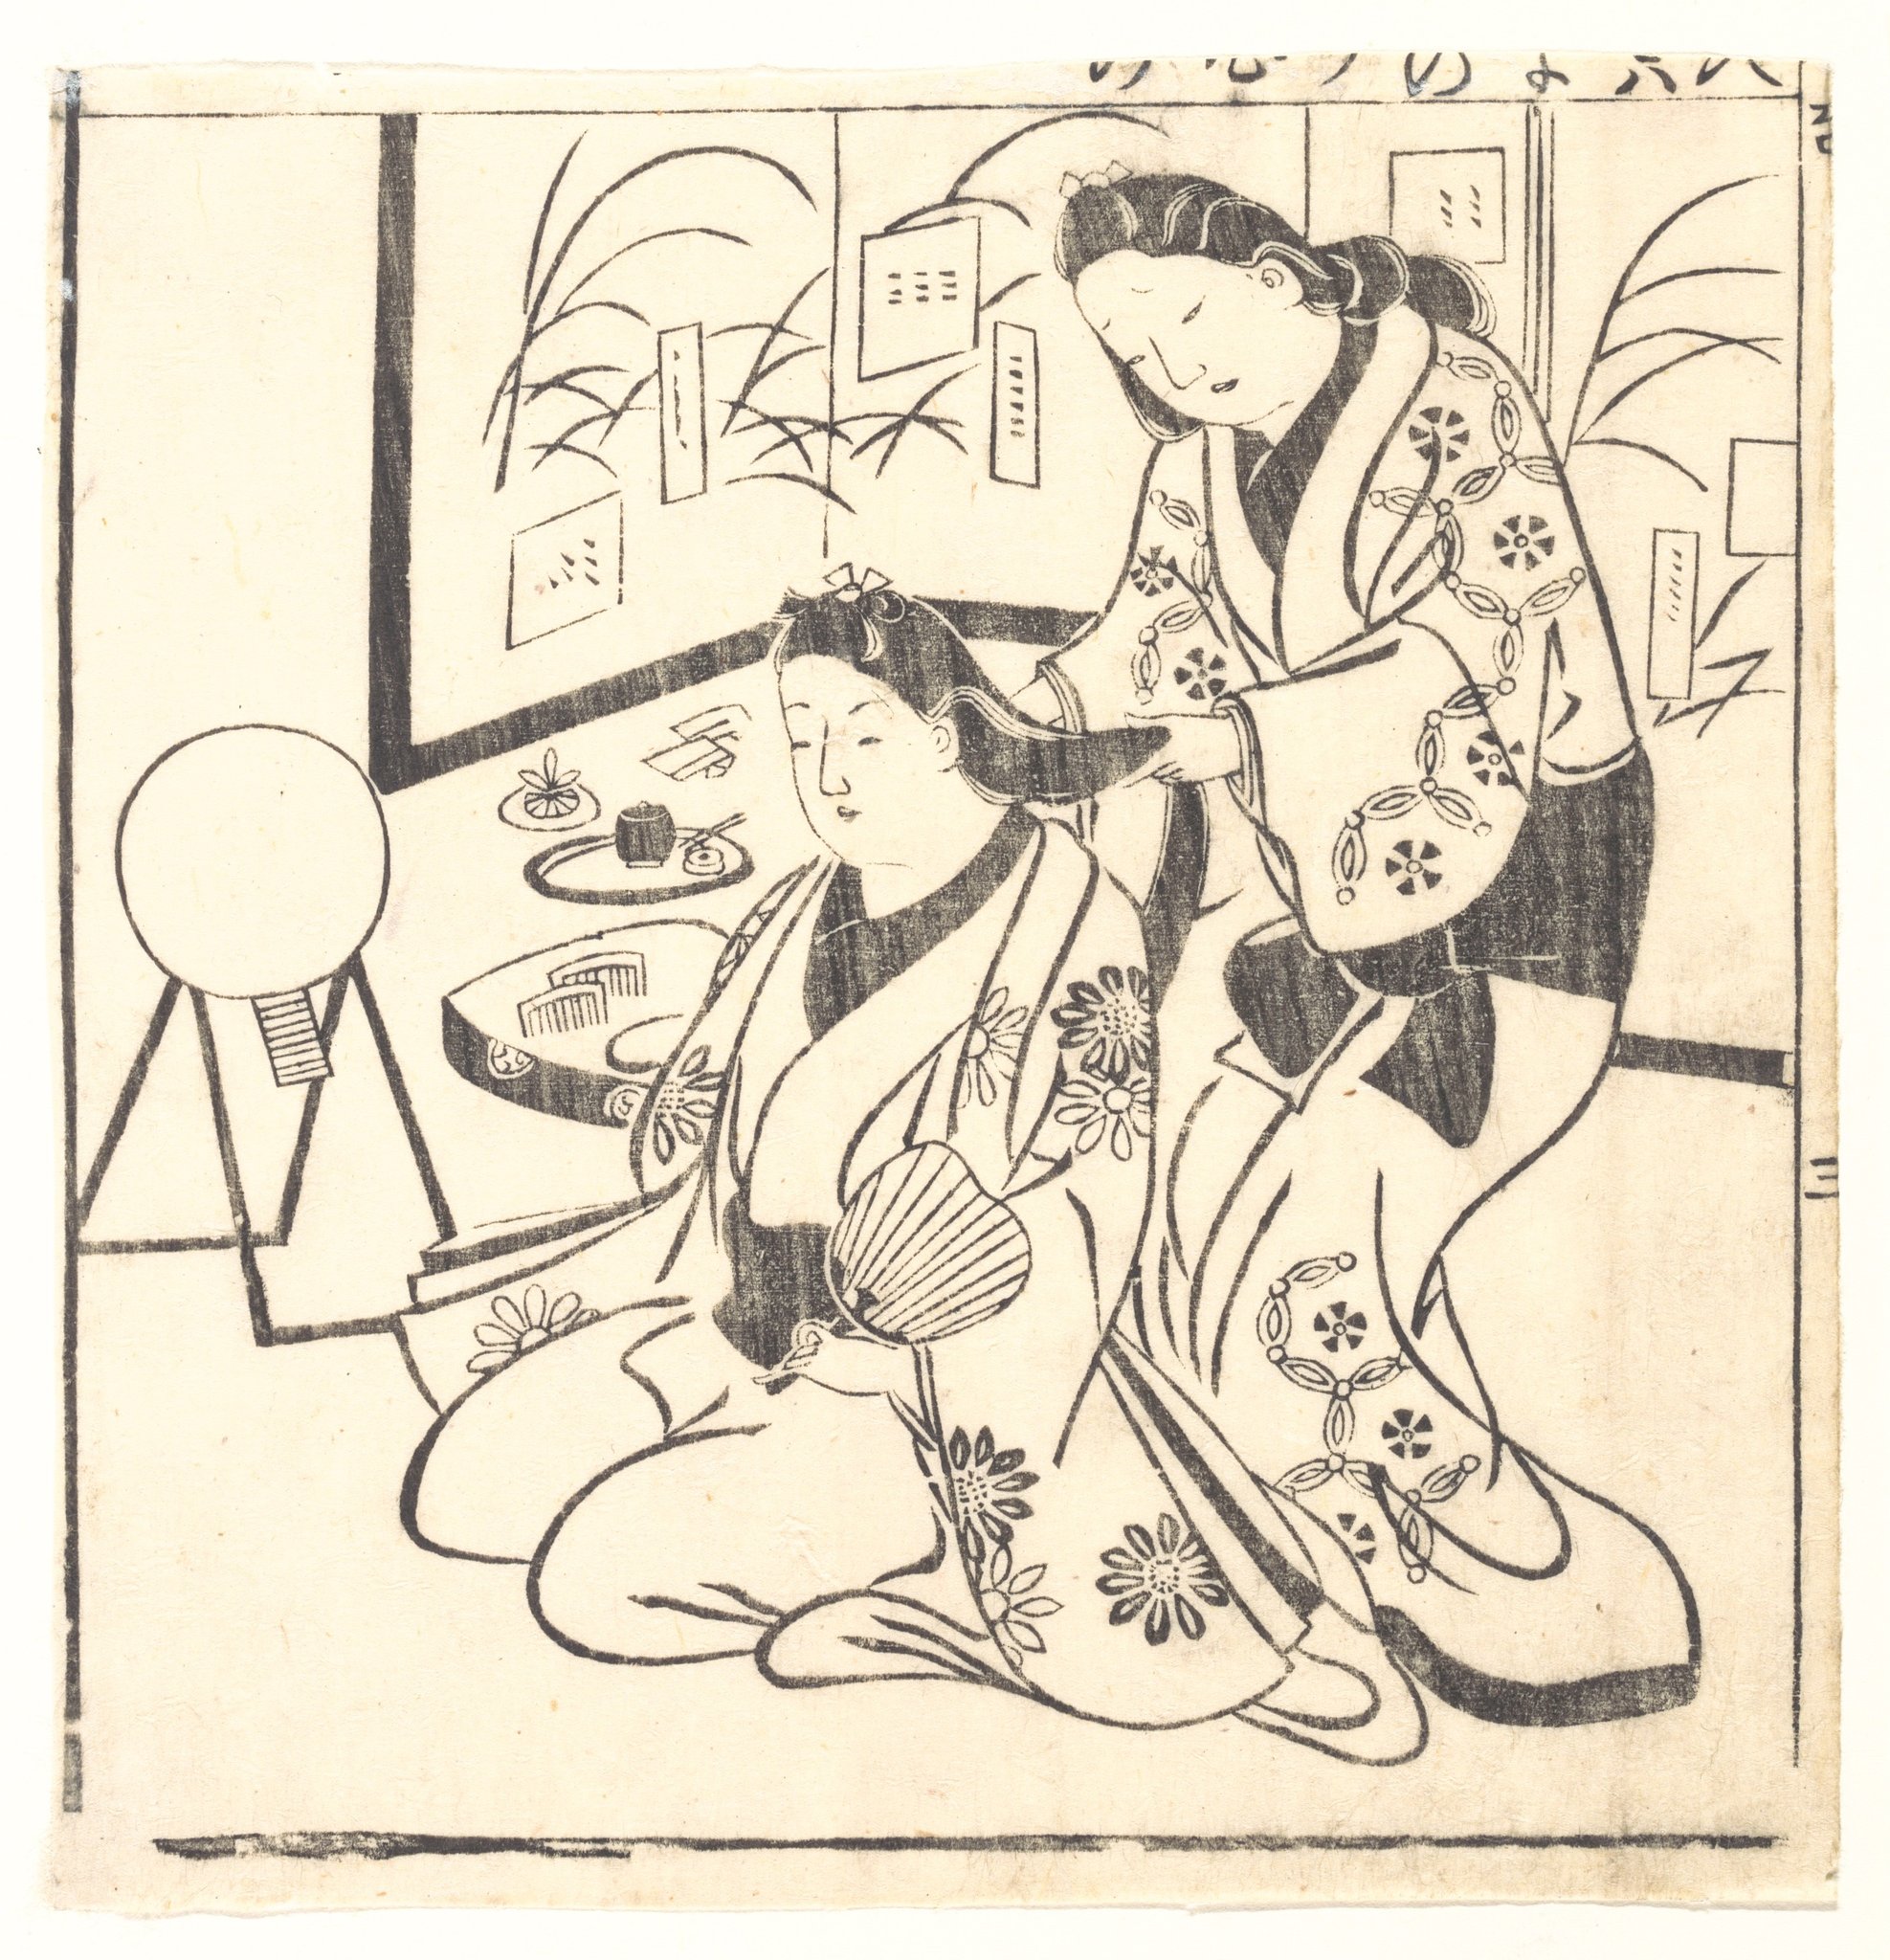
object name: woodblock print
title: Leaf from a Book Entitled: Wakoku Hiaku-jo, One Hundred Japanese Women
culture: japanese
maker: hishikawa moronobu 菱川師宣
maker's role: artist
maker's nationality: japanese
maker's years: 1618-1694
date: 1625-1694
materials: ink, paper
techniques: woodblock print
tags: hair,women,mirrors